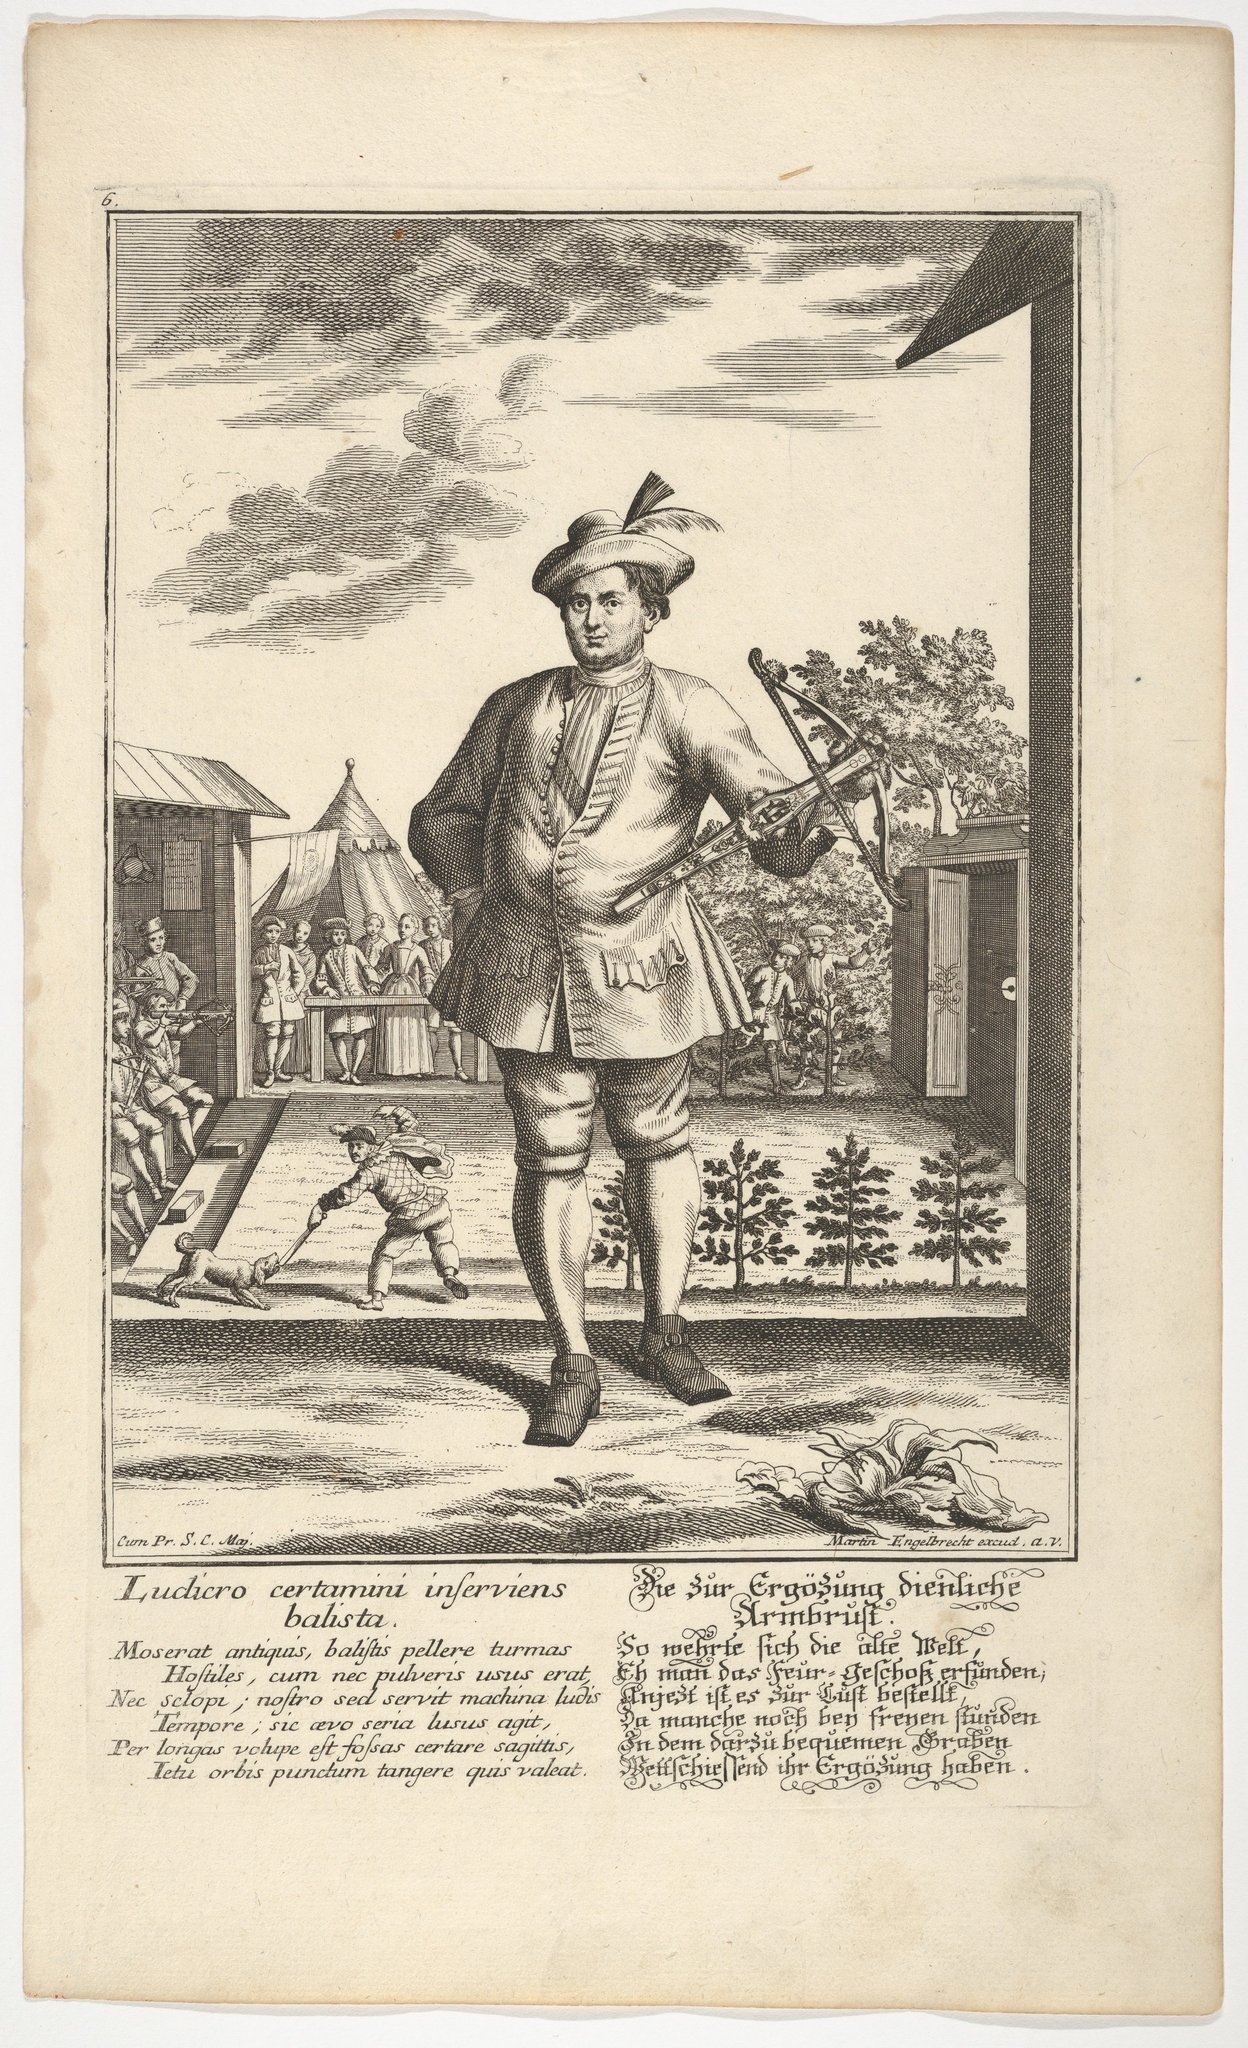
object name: print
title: Man Holding a Crossbow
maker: martin engelbrecht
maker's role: publisher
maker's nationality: german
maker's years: 1684-1756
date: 1710-1756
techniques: etching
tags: weapons,men